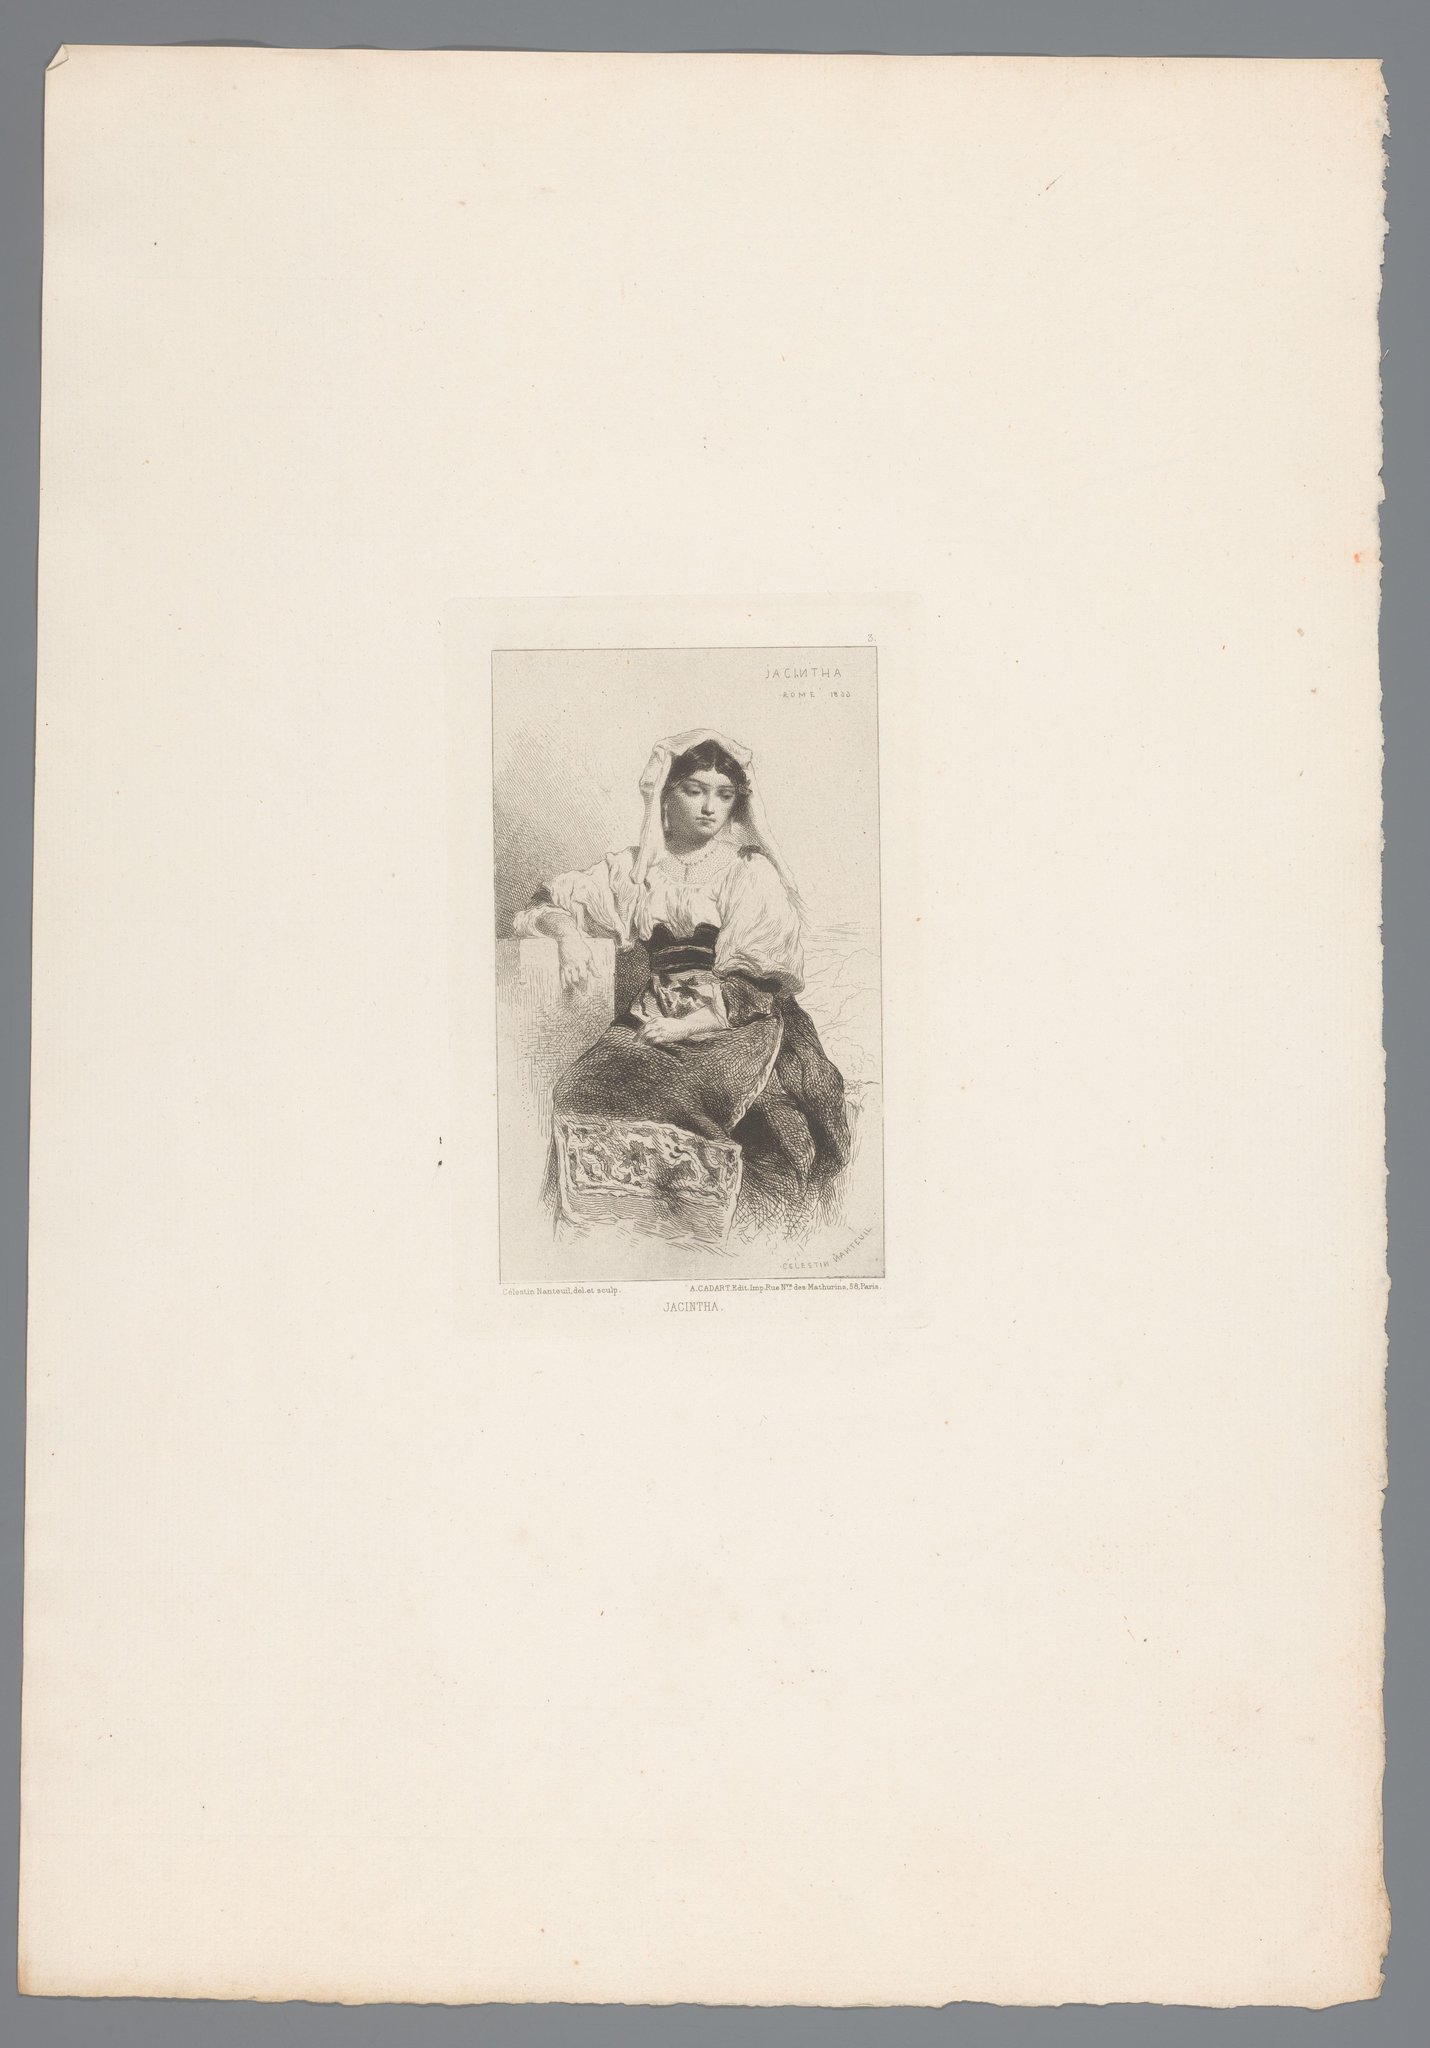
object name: print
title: Portret van Jacintha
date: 1866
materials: paper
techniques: etching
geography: rome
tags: historical persons not known by name - bb - woman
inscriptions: collector's mark: ‘AFE v S’, collector's mark: Lugt 2228, collector's mark: Lugt 2760, watermark